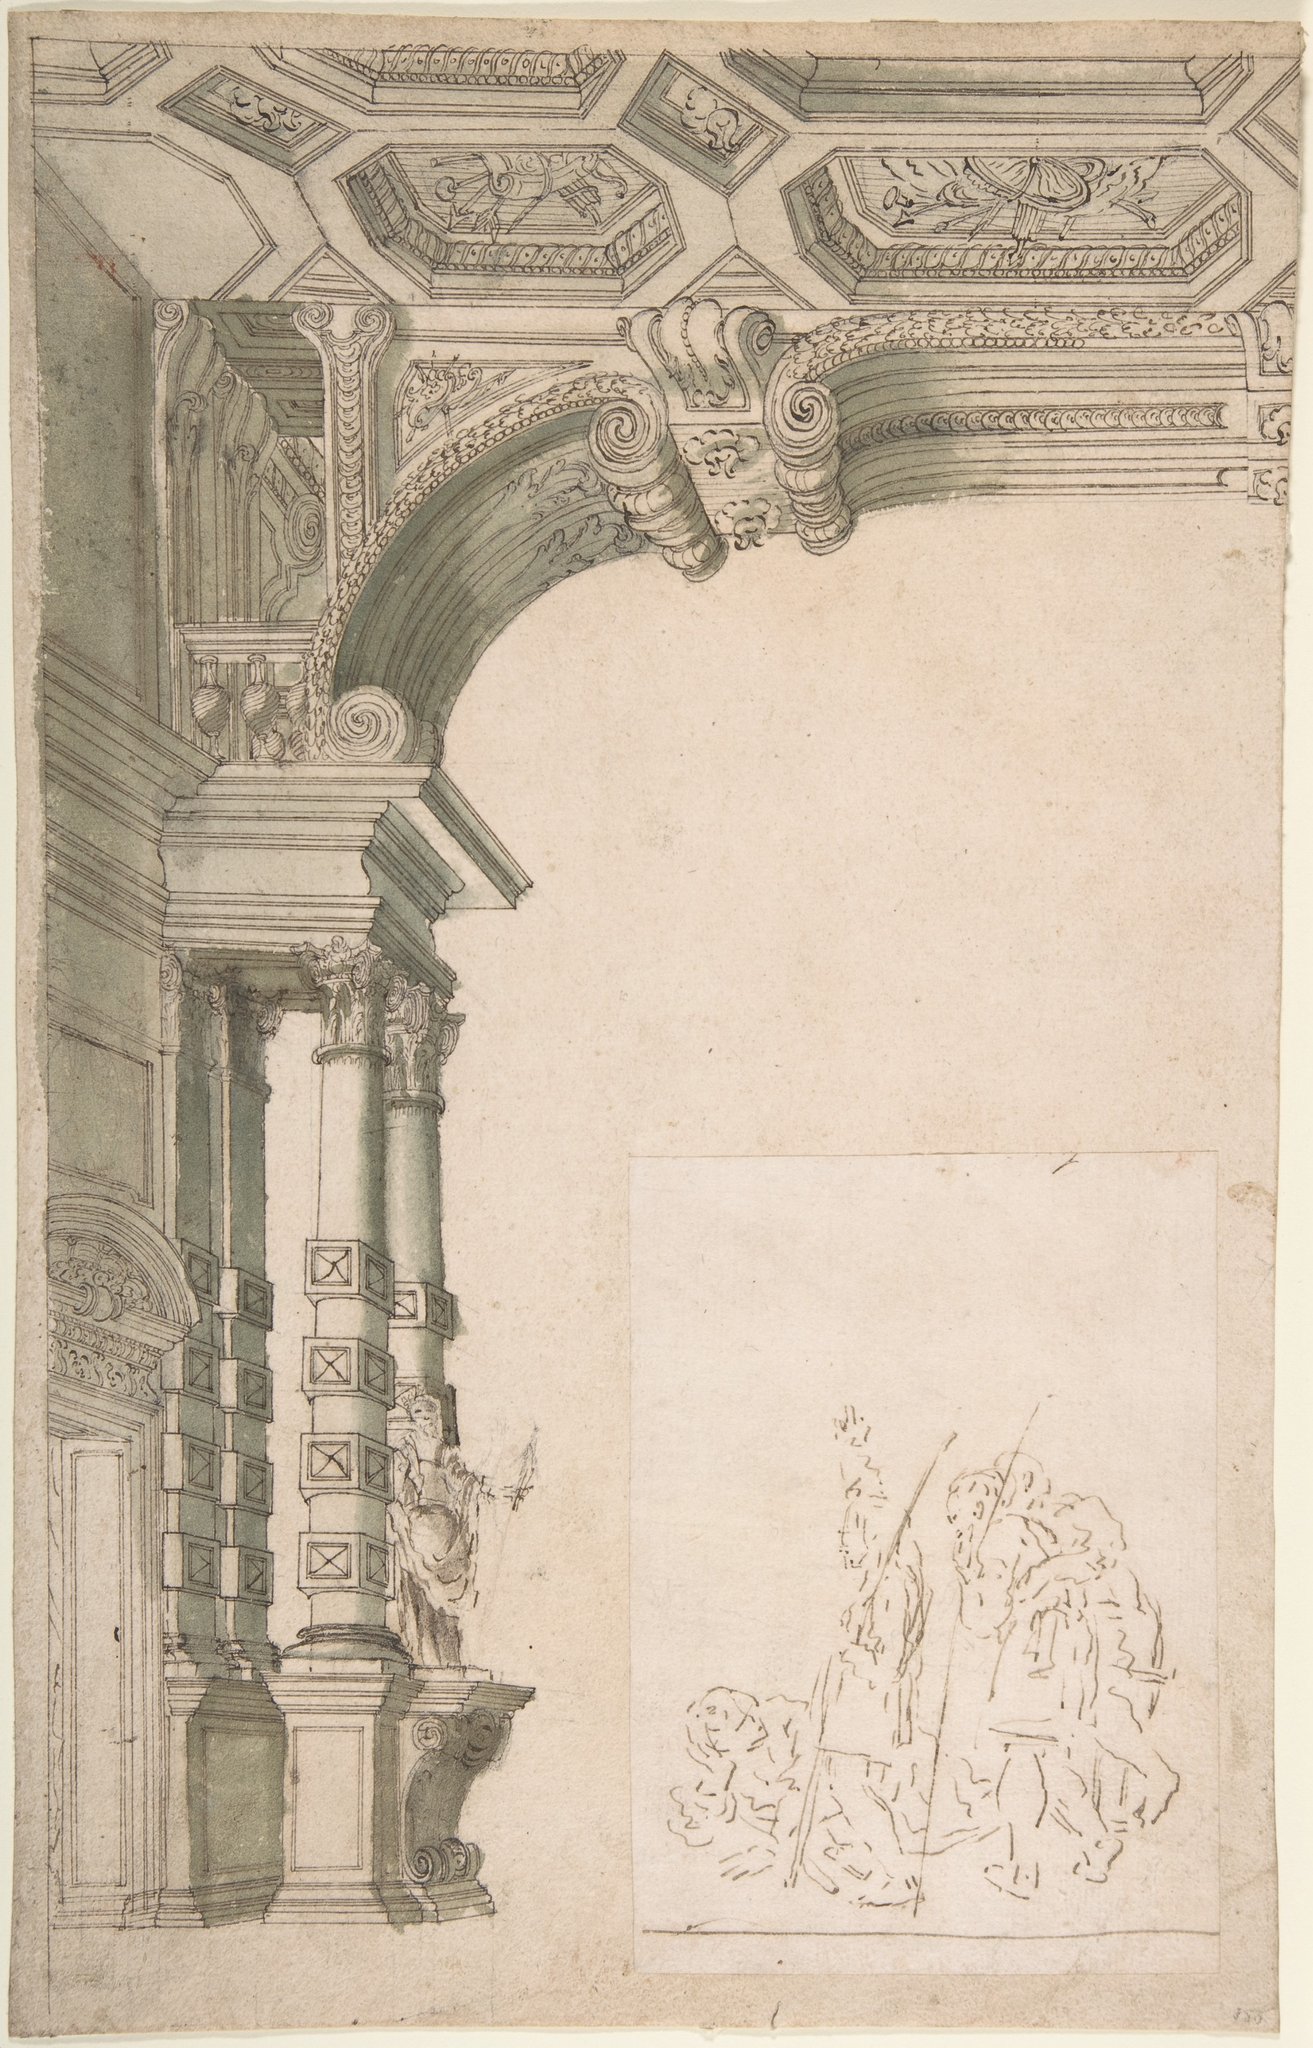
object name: drawing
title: One Half of a Design for an Arch, With a Figural Sketch Pasted at lower right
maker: anonymous, italian, piedmontese, 18th century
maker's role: artist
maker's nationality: italian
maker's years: 1700-1800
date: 1700-1780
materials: chalk, graphite, ink, drawing material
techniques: brush, pen, wash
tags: architecture